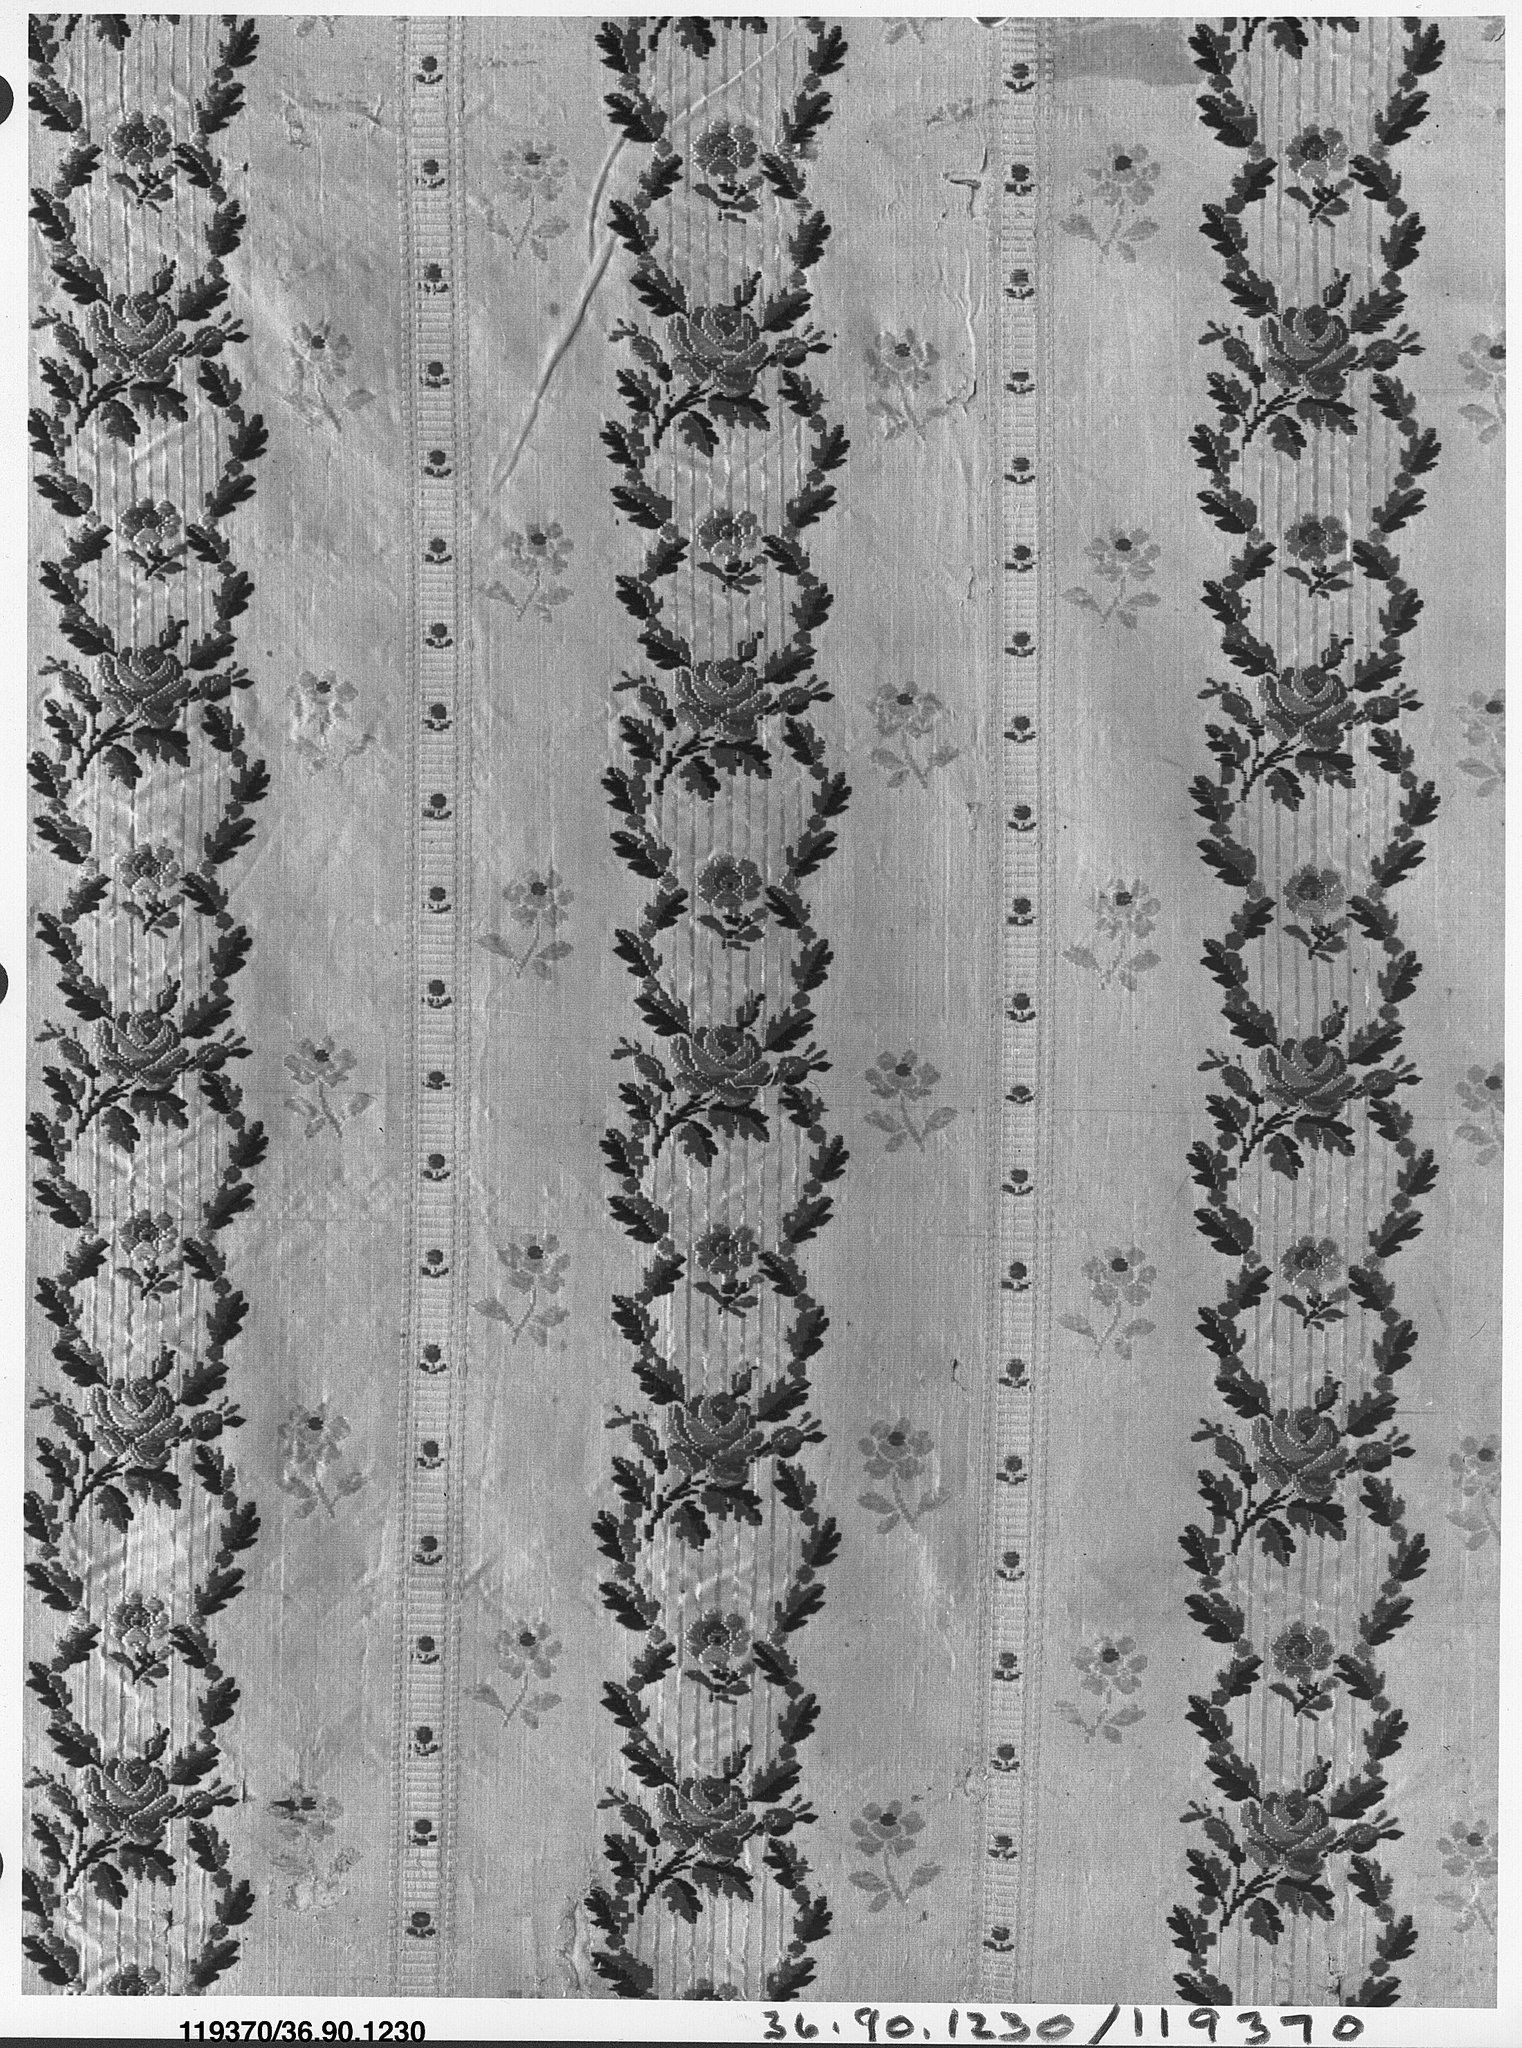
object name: piece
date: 1780-1790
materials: silk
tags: flowers,leaves